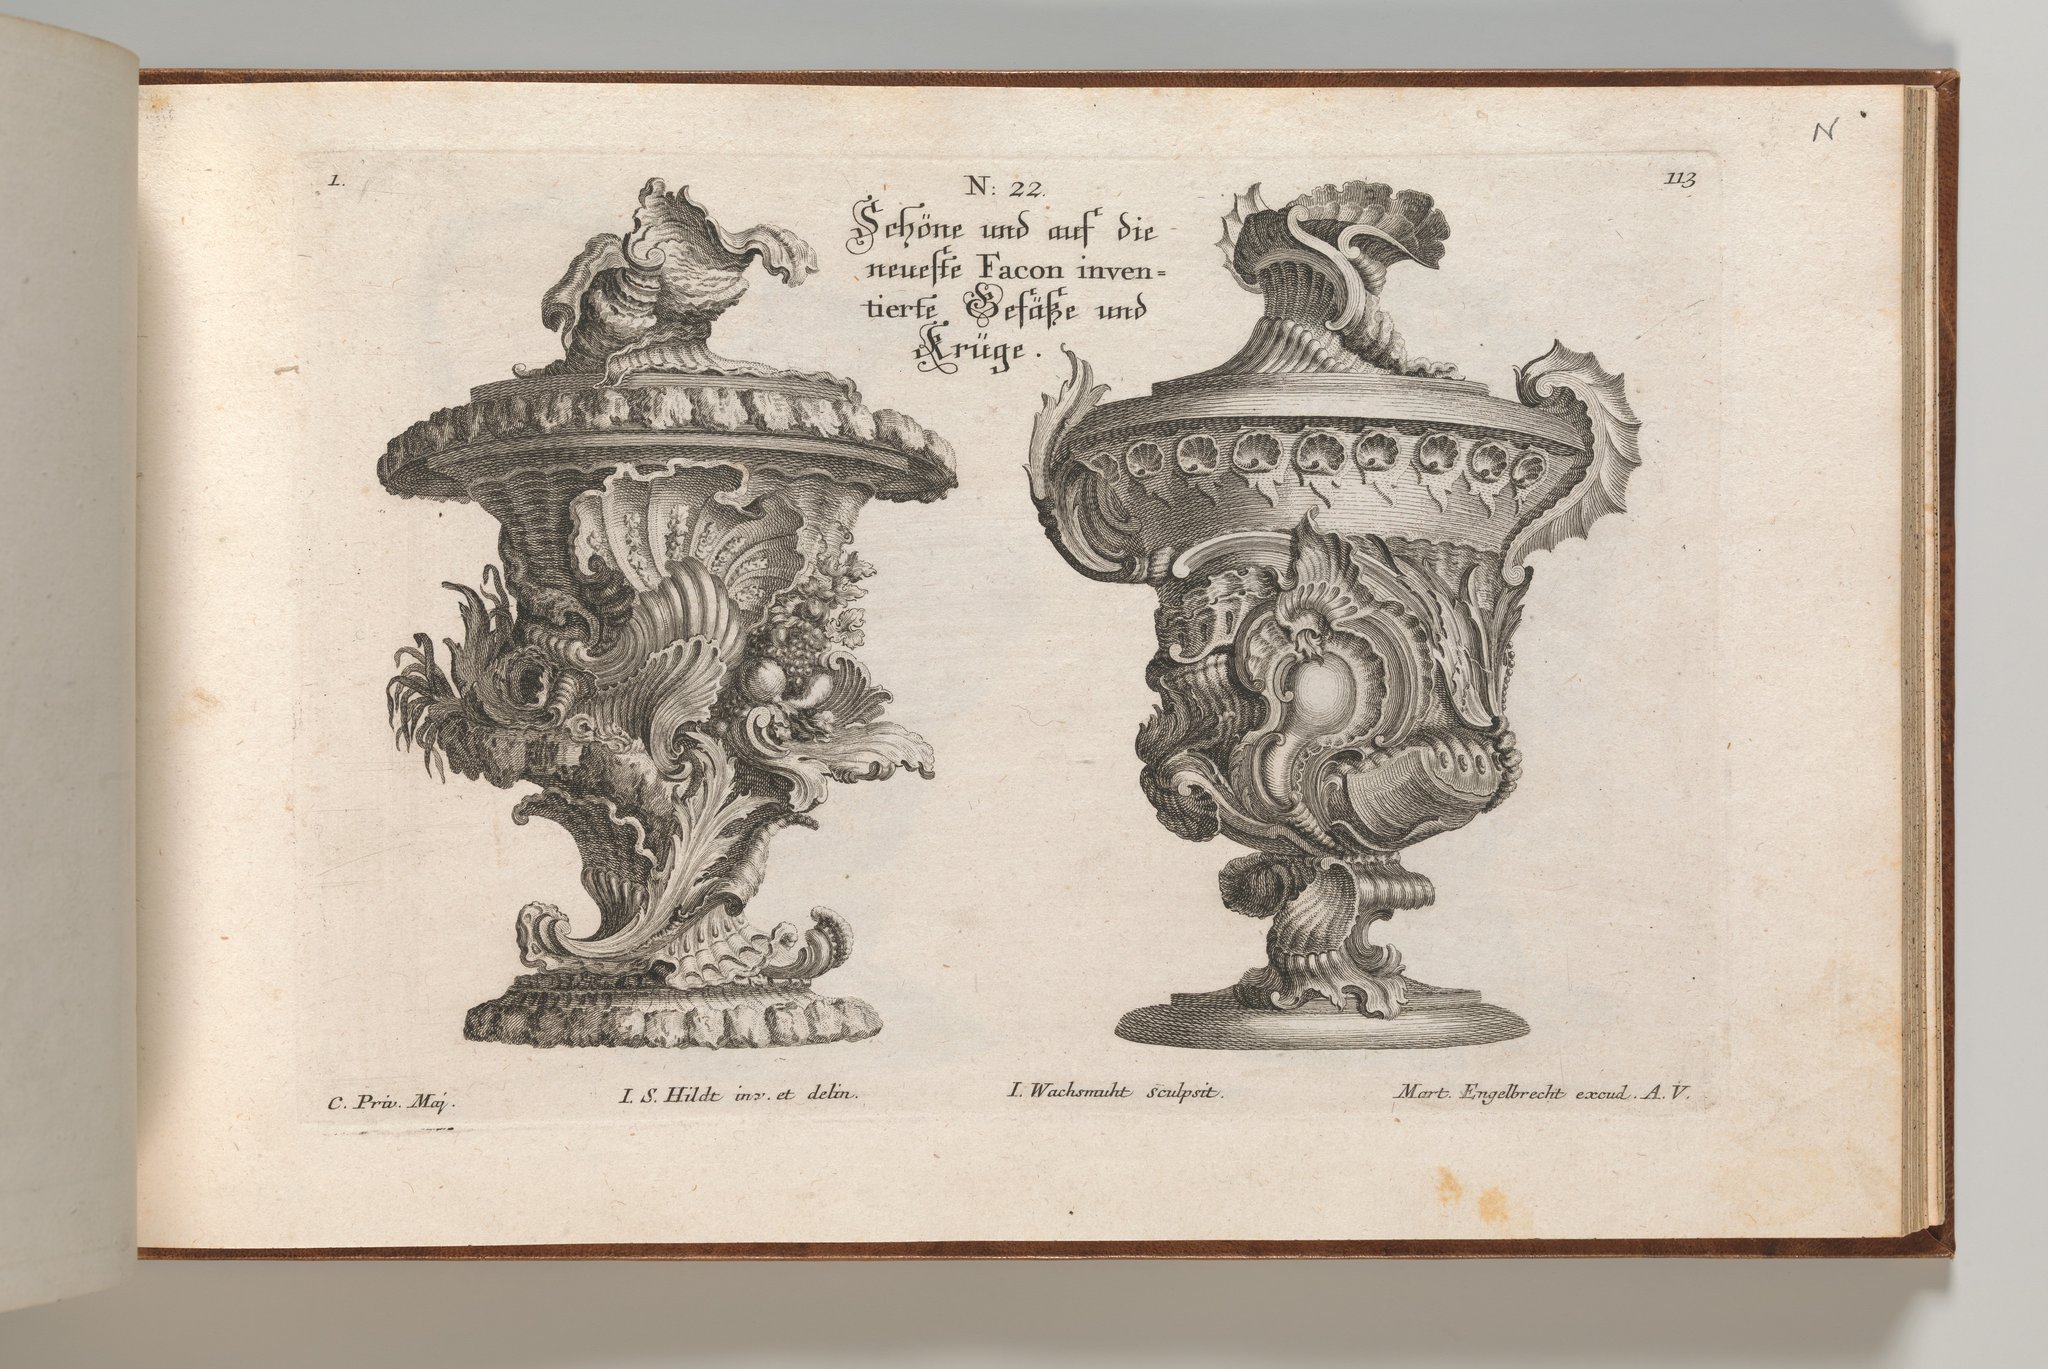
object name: album print ornament architecture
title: Designs for Two Lidded Vases, Plate 1 from: 'Schöne und auf die neueste Facon inventierte Gefäße und Krüge'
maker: jeremias wachsmuth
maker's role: artist and engraver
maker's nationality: german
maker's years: 1712-1771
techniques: etching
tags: vases